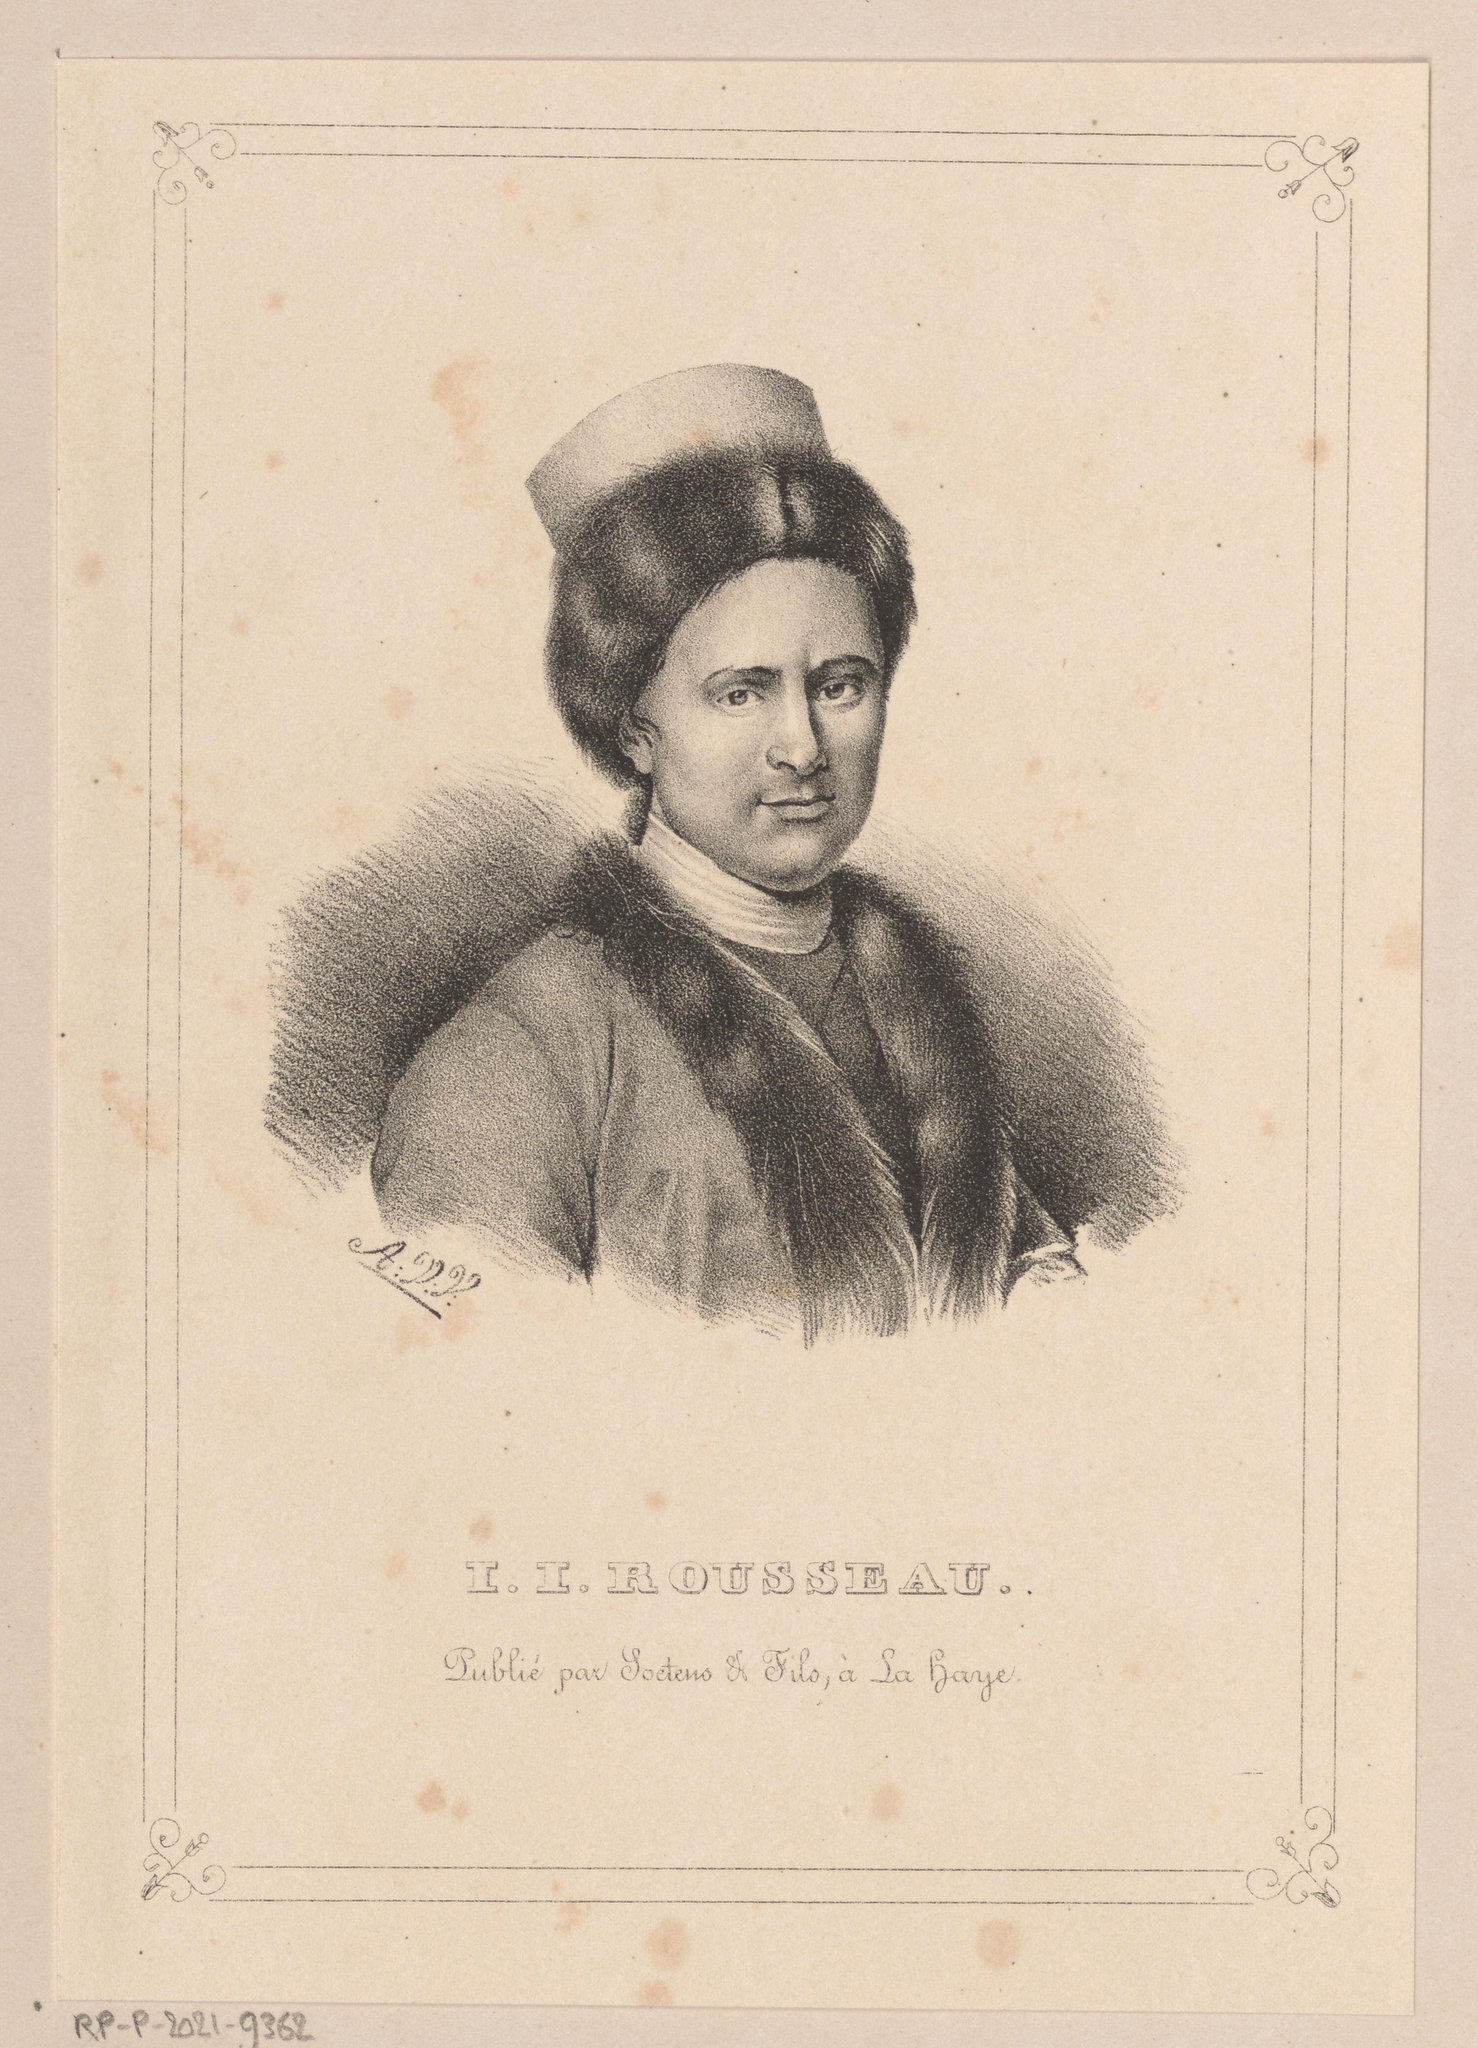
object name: print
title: Portret van Jean-Jacques Rousseau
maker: anthonie van volkom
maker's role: print maker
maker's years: 1821-1860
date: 1837-1840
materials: paper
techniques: lithograph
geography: the hague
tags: historical persons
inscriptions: signature: ‘A.V.B.’